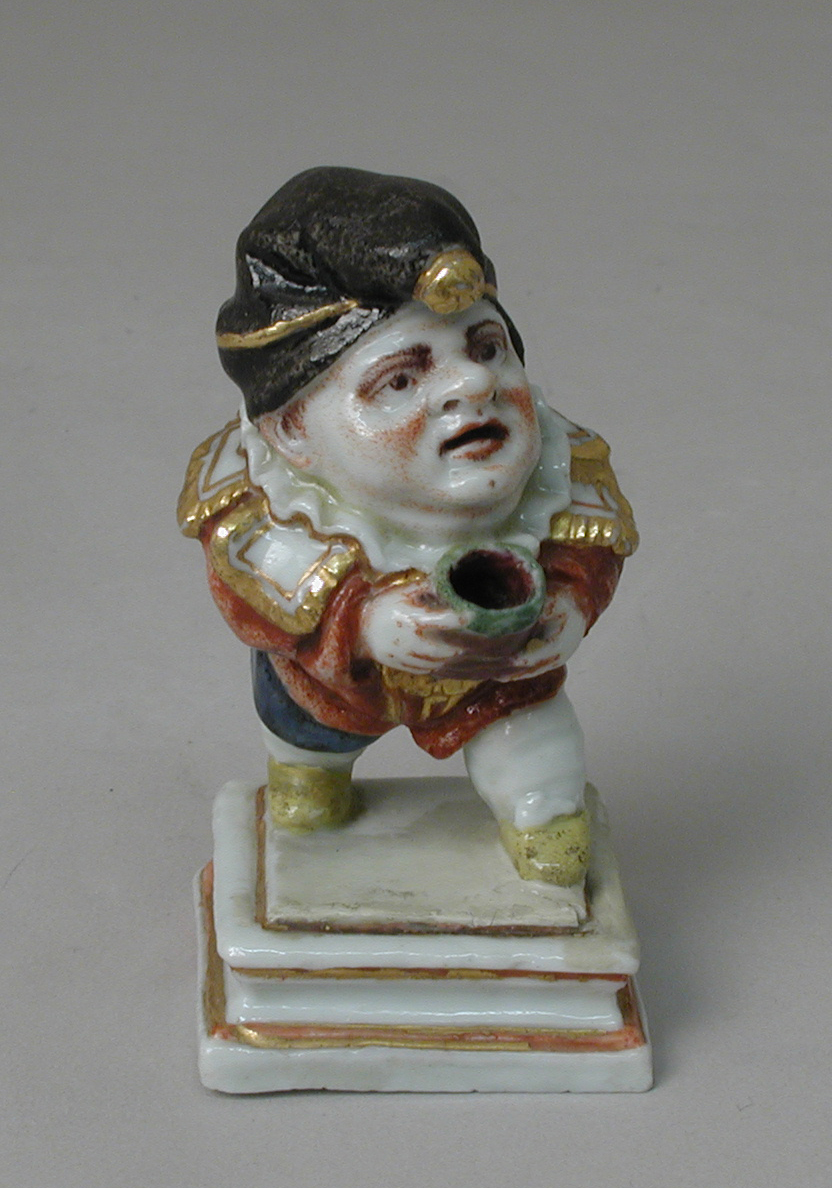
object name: figure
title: Dwarf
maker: doccia porcelain manufactory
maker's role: manufactory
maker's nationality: italian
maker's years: 1737-1896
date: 1760-1770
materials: hard paste porcelain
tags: men